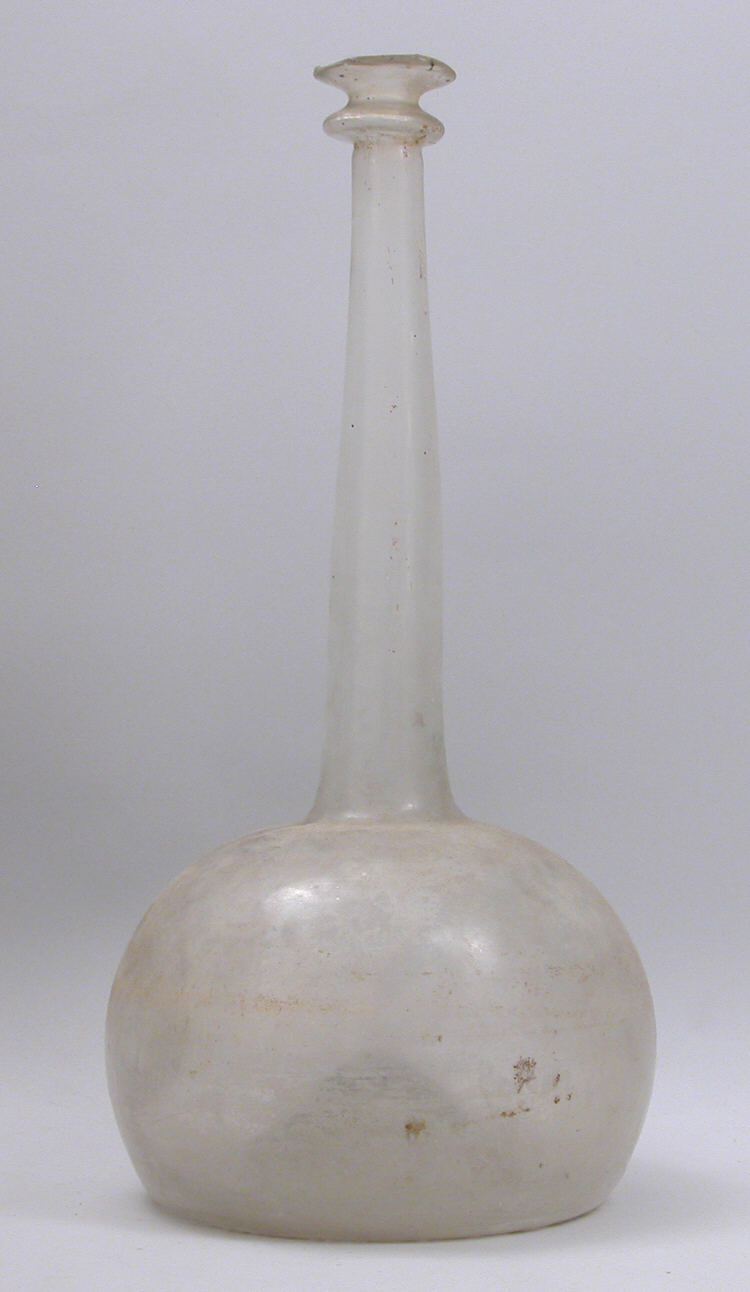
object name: bottle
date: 1701-1900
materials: glass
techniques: glassblowing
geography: iran